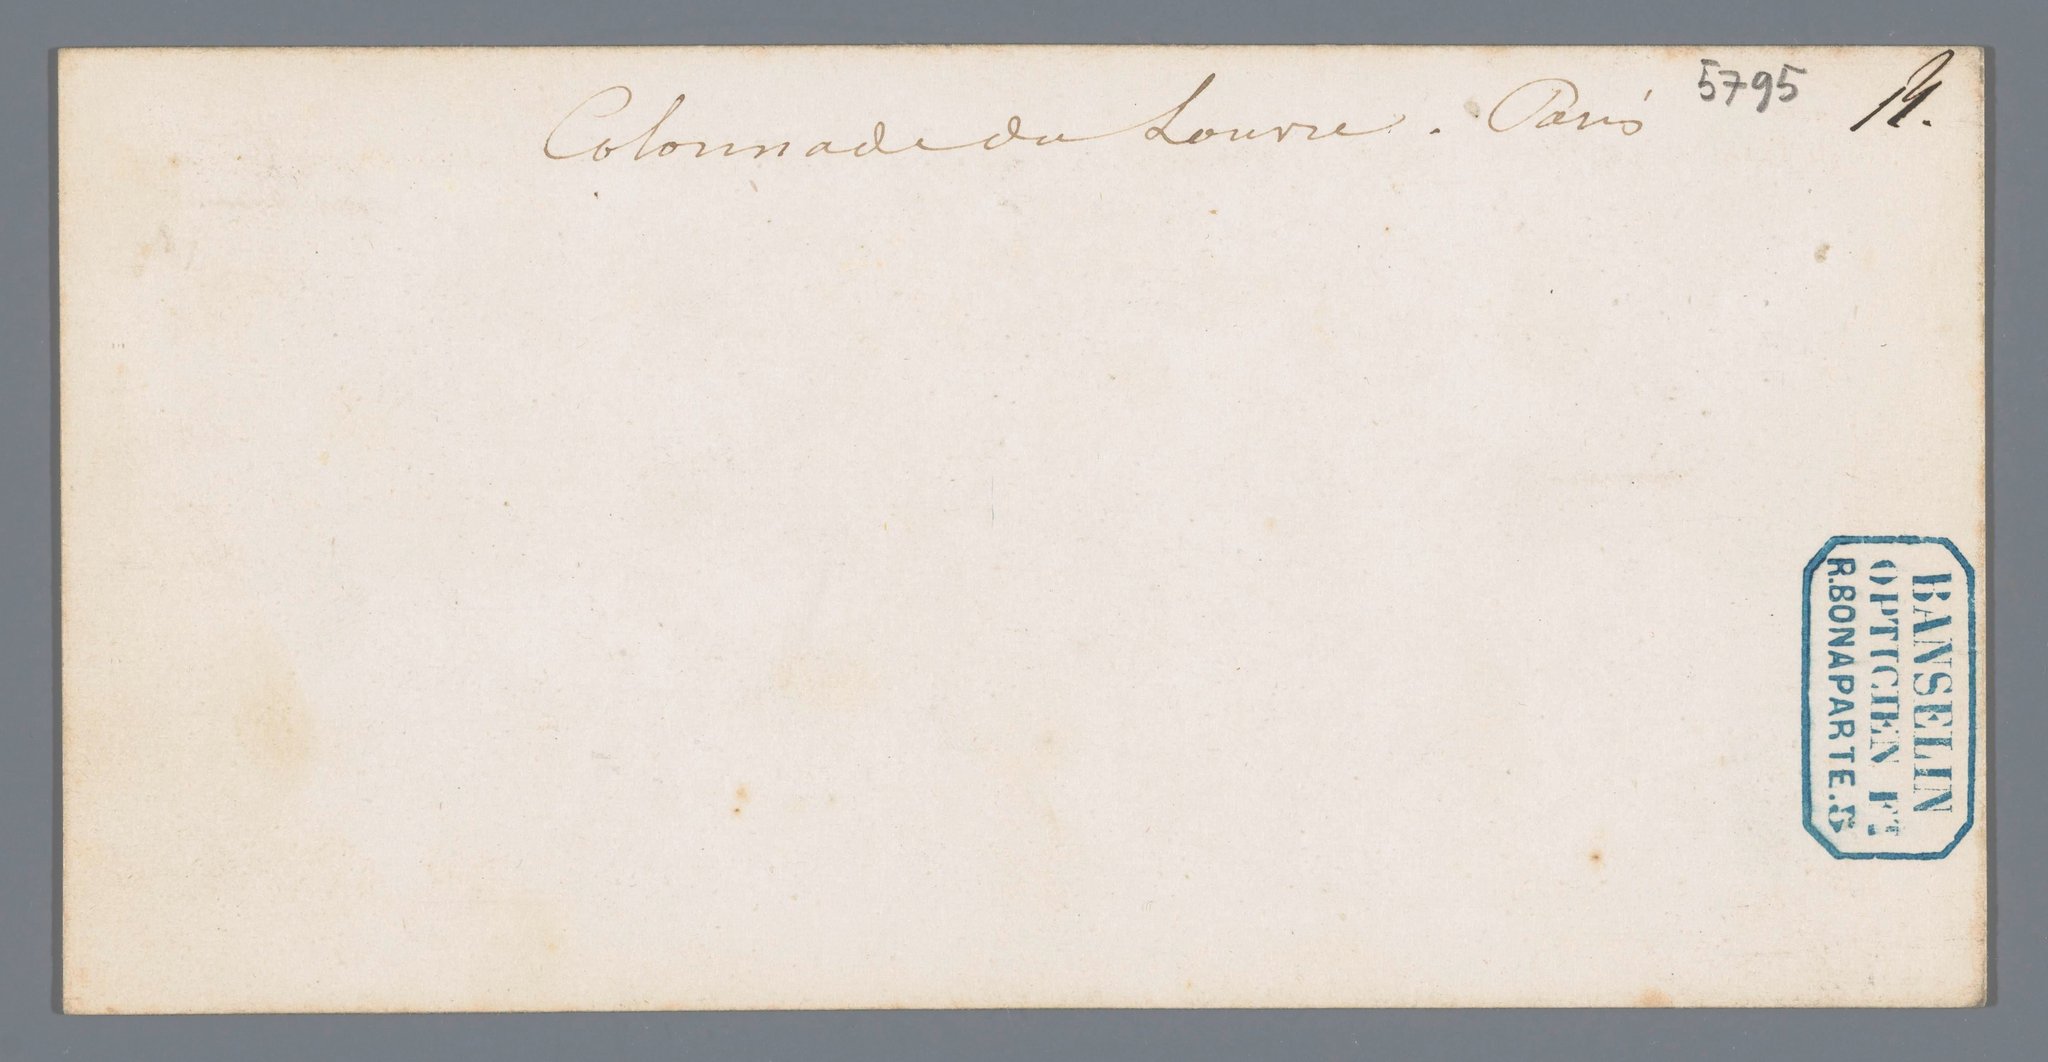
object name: stereograph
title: Gezicht op de Colonnade du Louvre van het Palais du Louvre in Parijs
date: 1850-1870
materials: cardboard, photographic support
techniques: albumen print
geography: paris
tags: colonnade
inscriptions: inscription: ‘Colonnade du Louvre, Paris’, number: ‘14.’, name: ‘Banselin Opticien Ft R.Bonaparte.5’